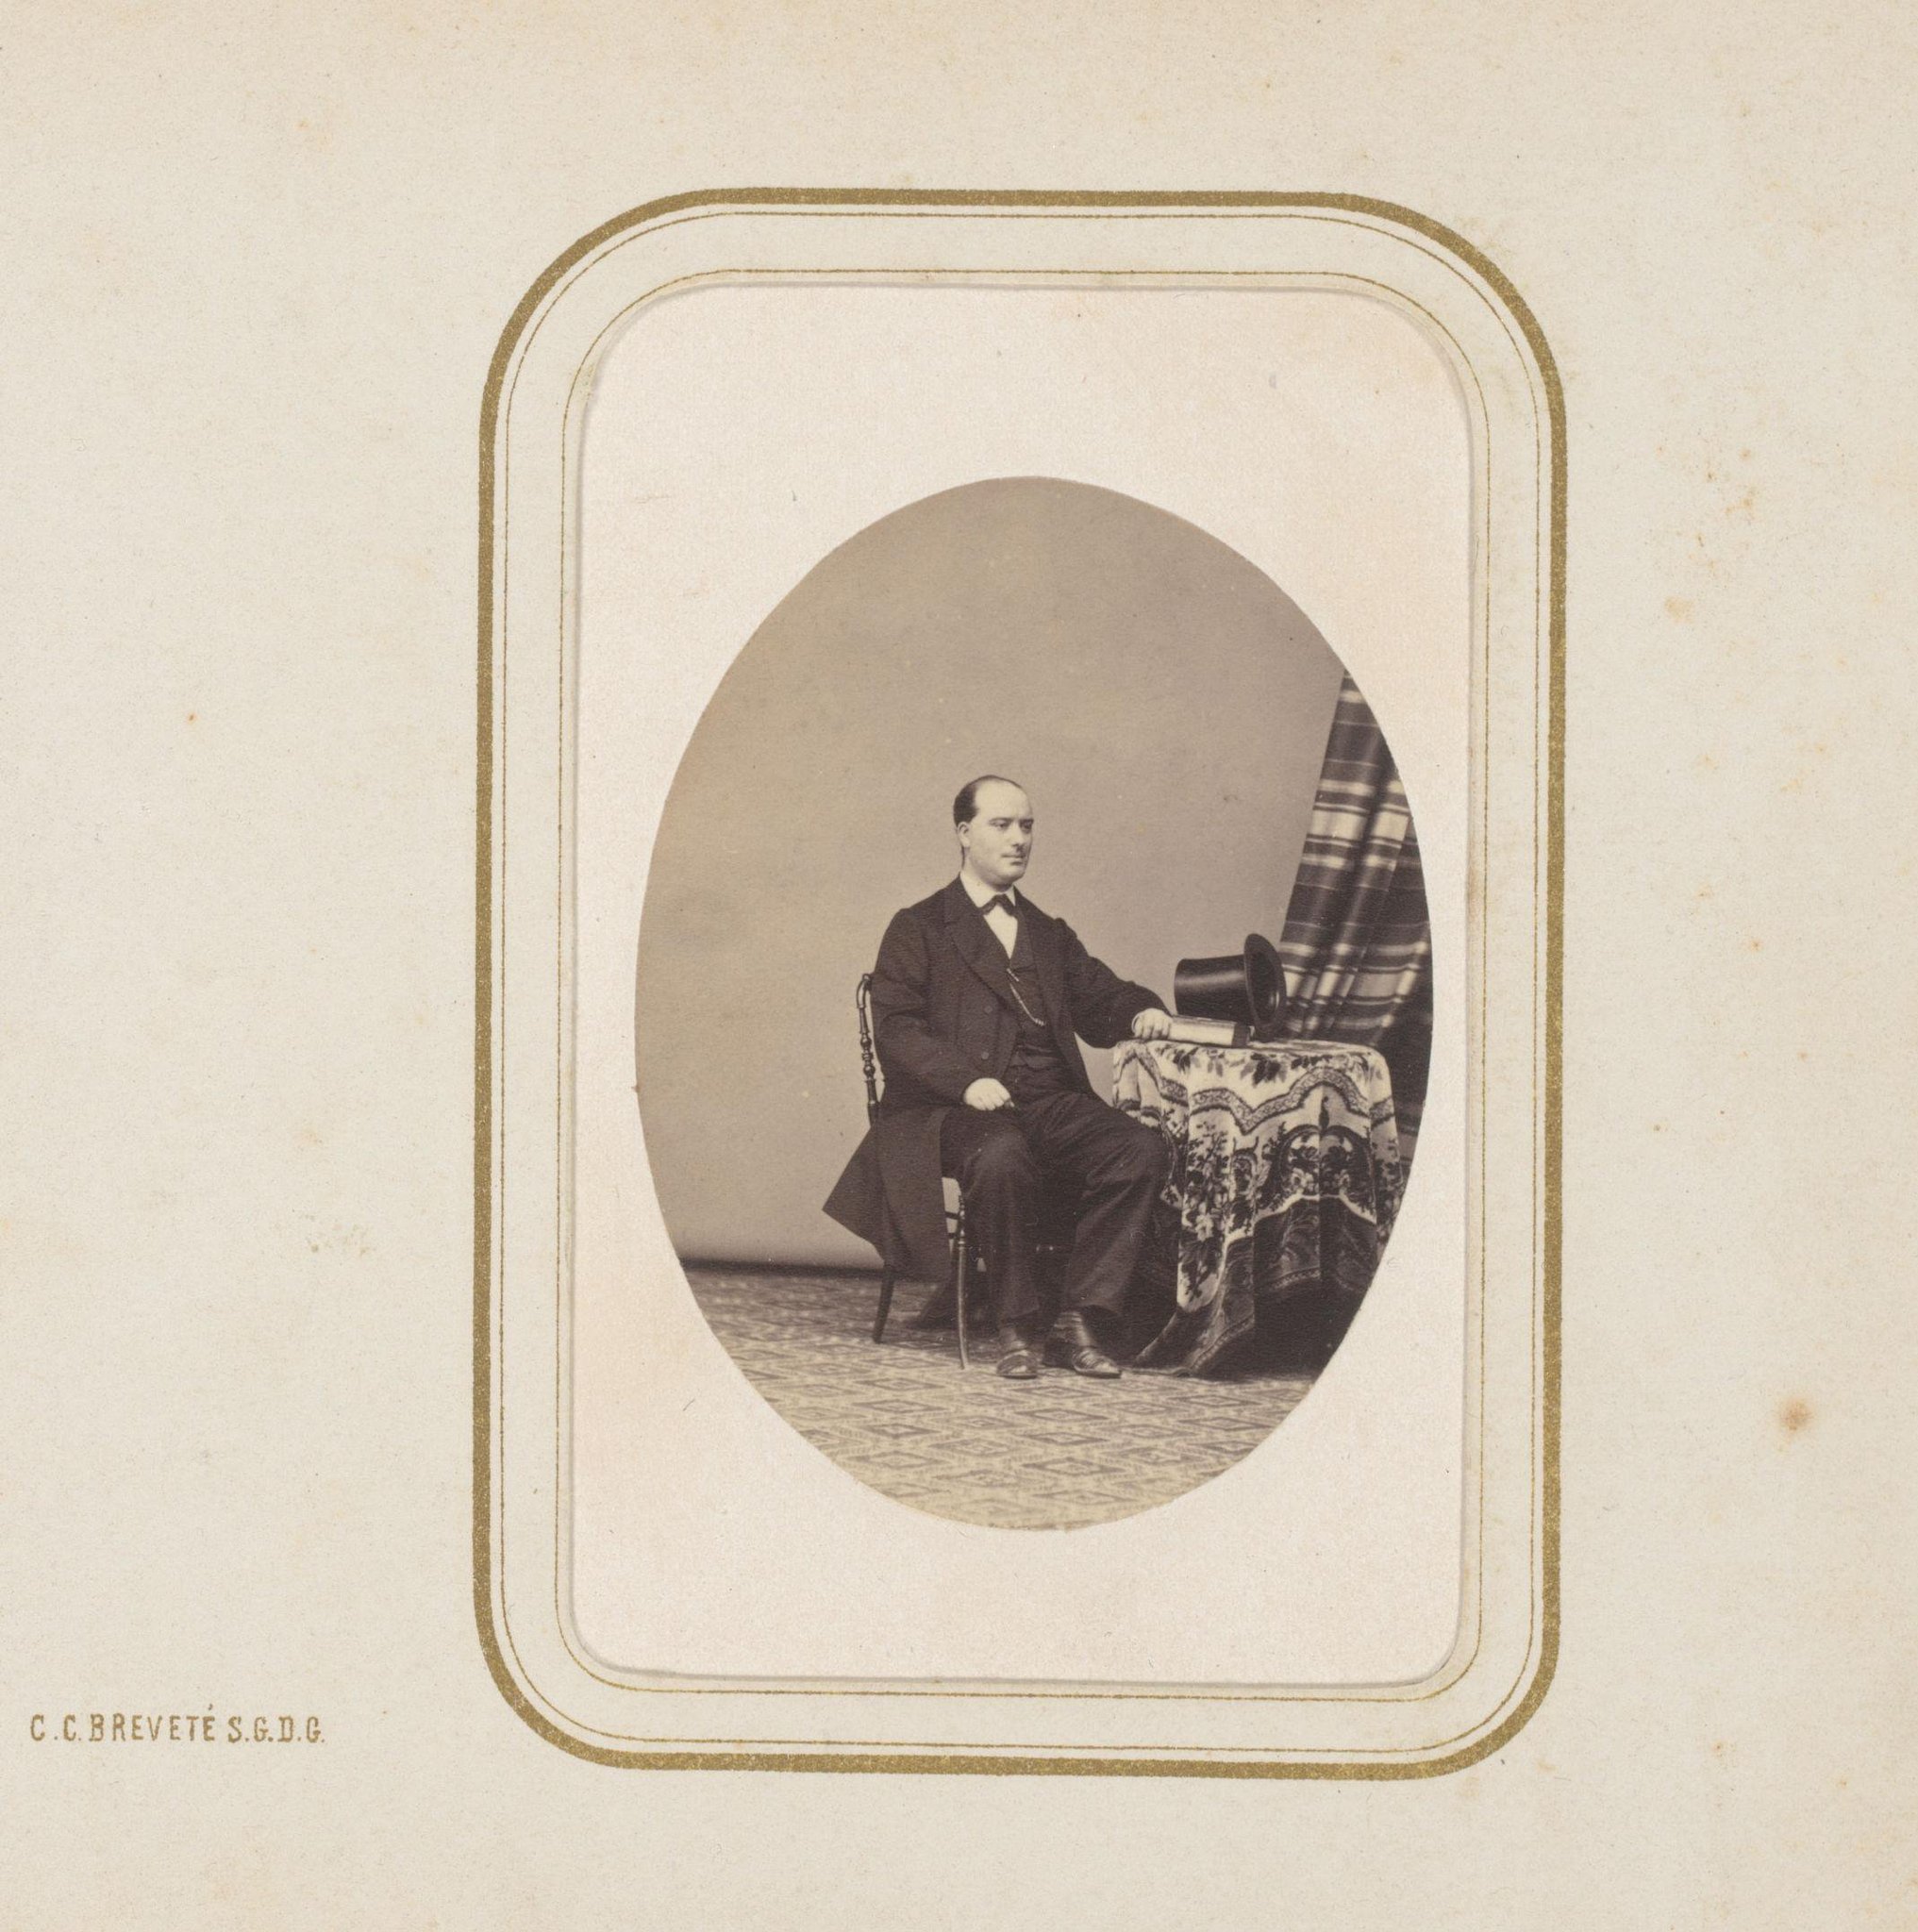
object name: album leaf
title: Portret van een man, zittend aan tafel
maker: josé garcía ayola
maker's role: fotograaf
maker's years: 1836-1900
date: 1860-1900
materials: cardboard, photographic support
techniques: albumen print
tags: sitting figure, adult man, historical persons, table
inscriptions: annotation: ‘A mi destinguida amiga/ [...] Iran. Me/ [...] en prueba de/ consideración y aprecio’, inscription: ‘J. G. Ayola/ Fotografo/ Calle de Genil/ Carrera de [...] 26/ Granada’